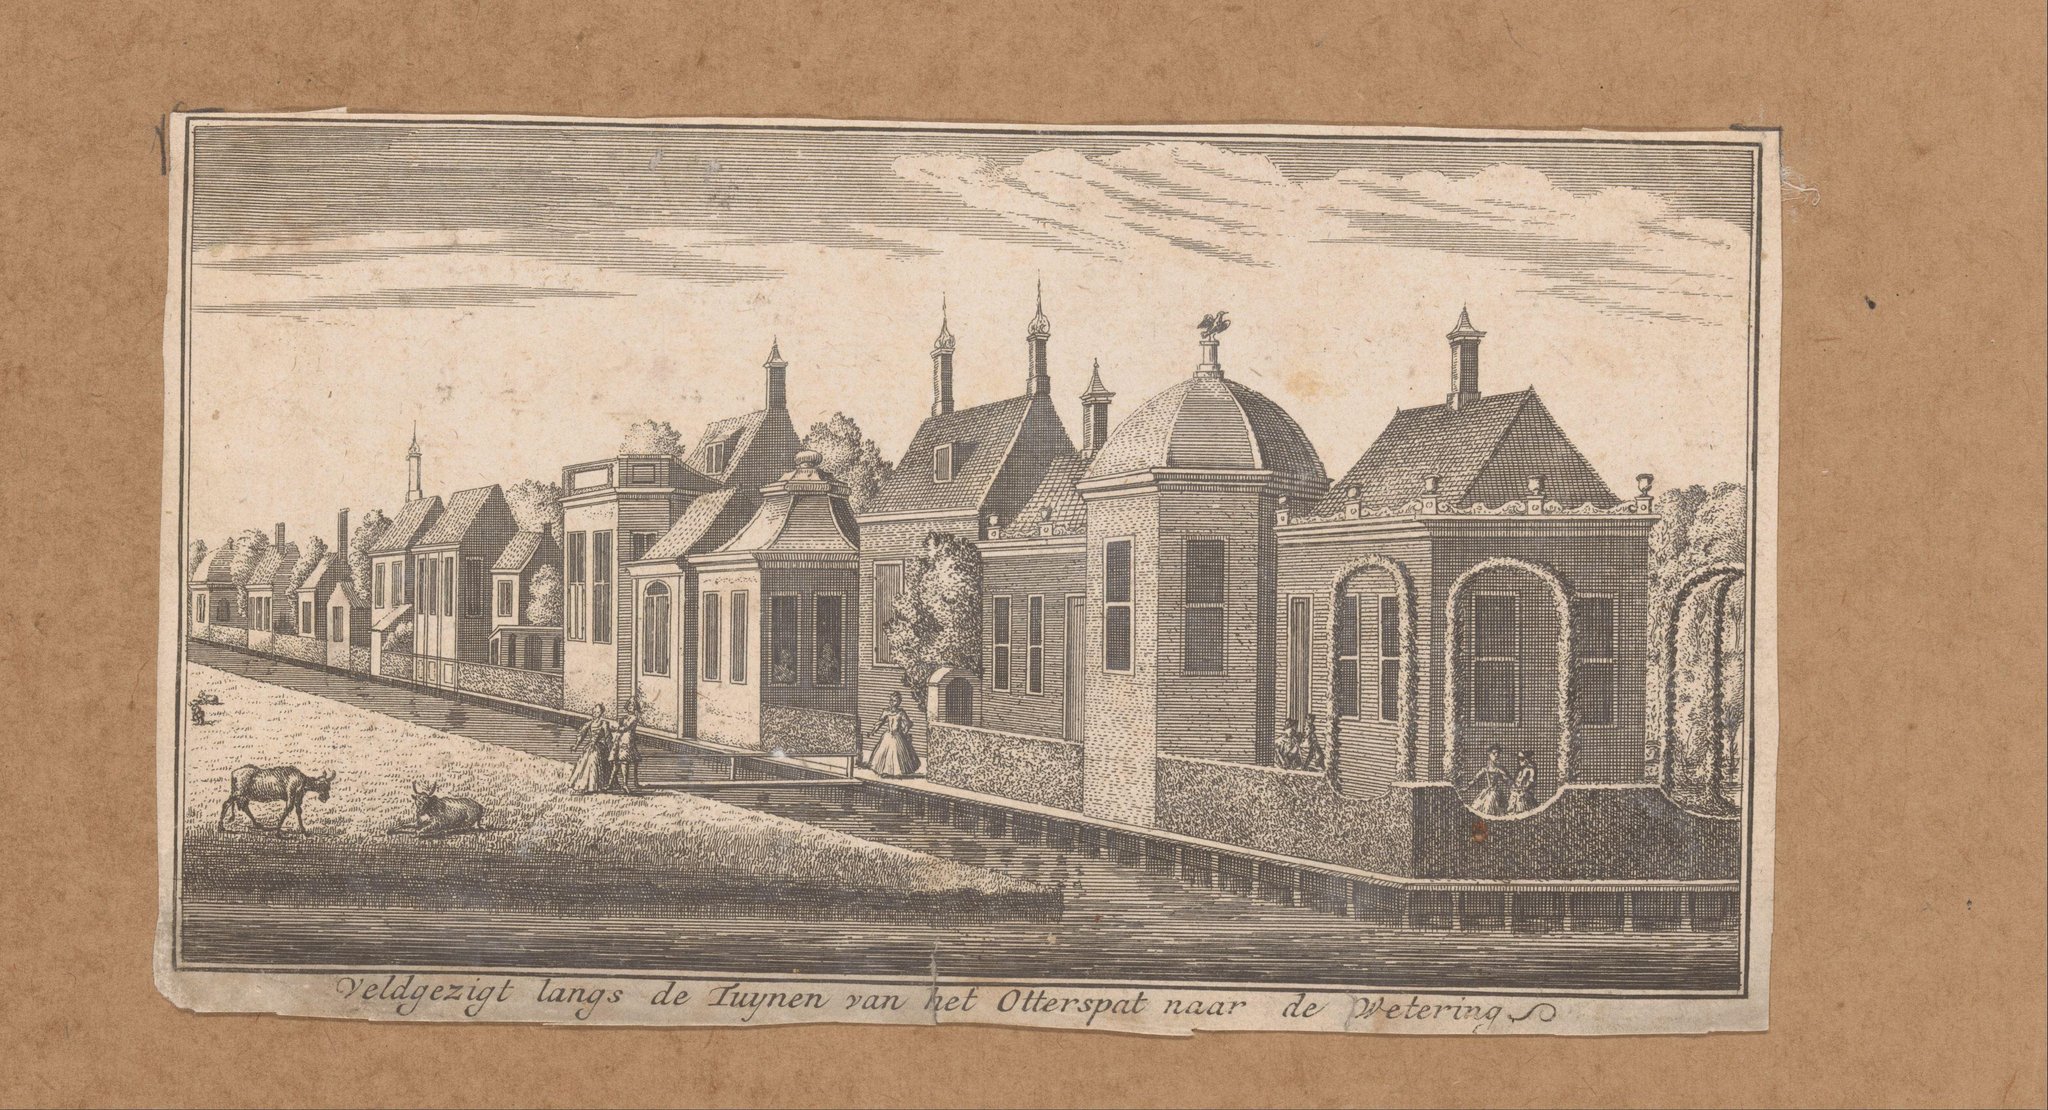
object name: print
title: Gezicht op de tuinen bij het Otterspad aan een wetering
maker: gerardus condet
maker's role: print maker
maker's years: 1715-1764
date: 1725-1764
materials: paper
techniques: etching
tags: garden, bridge in city across river, canal, etc., goat